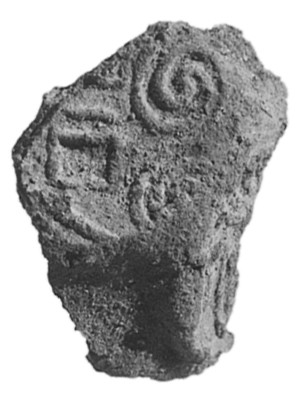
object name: sealing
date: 2030-1640 BCE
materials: clay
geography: egypt